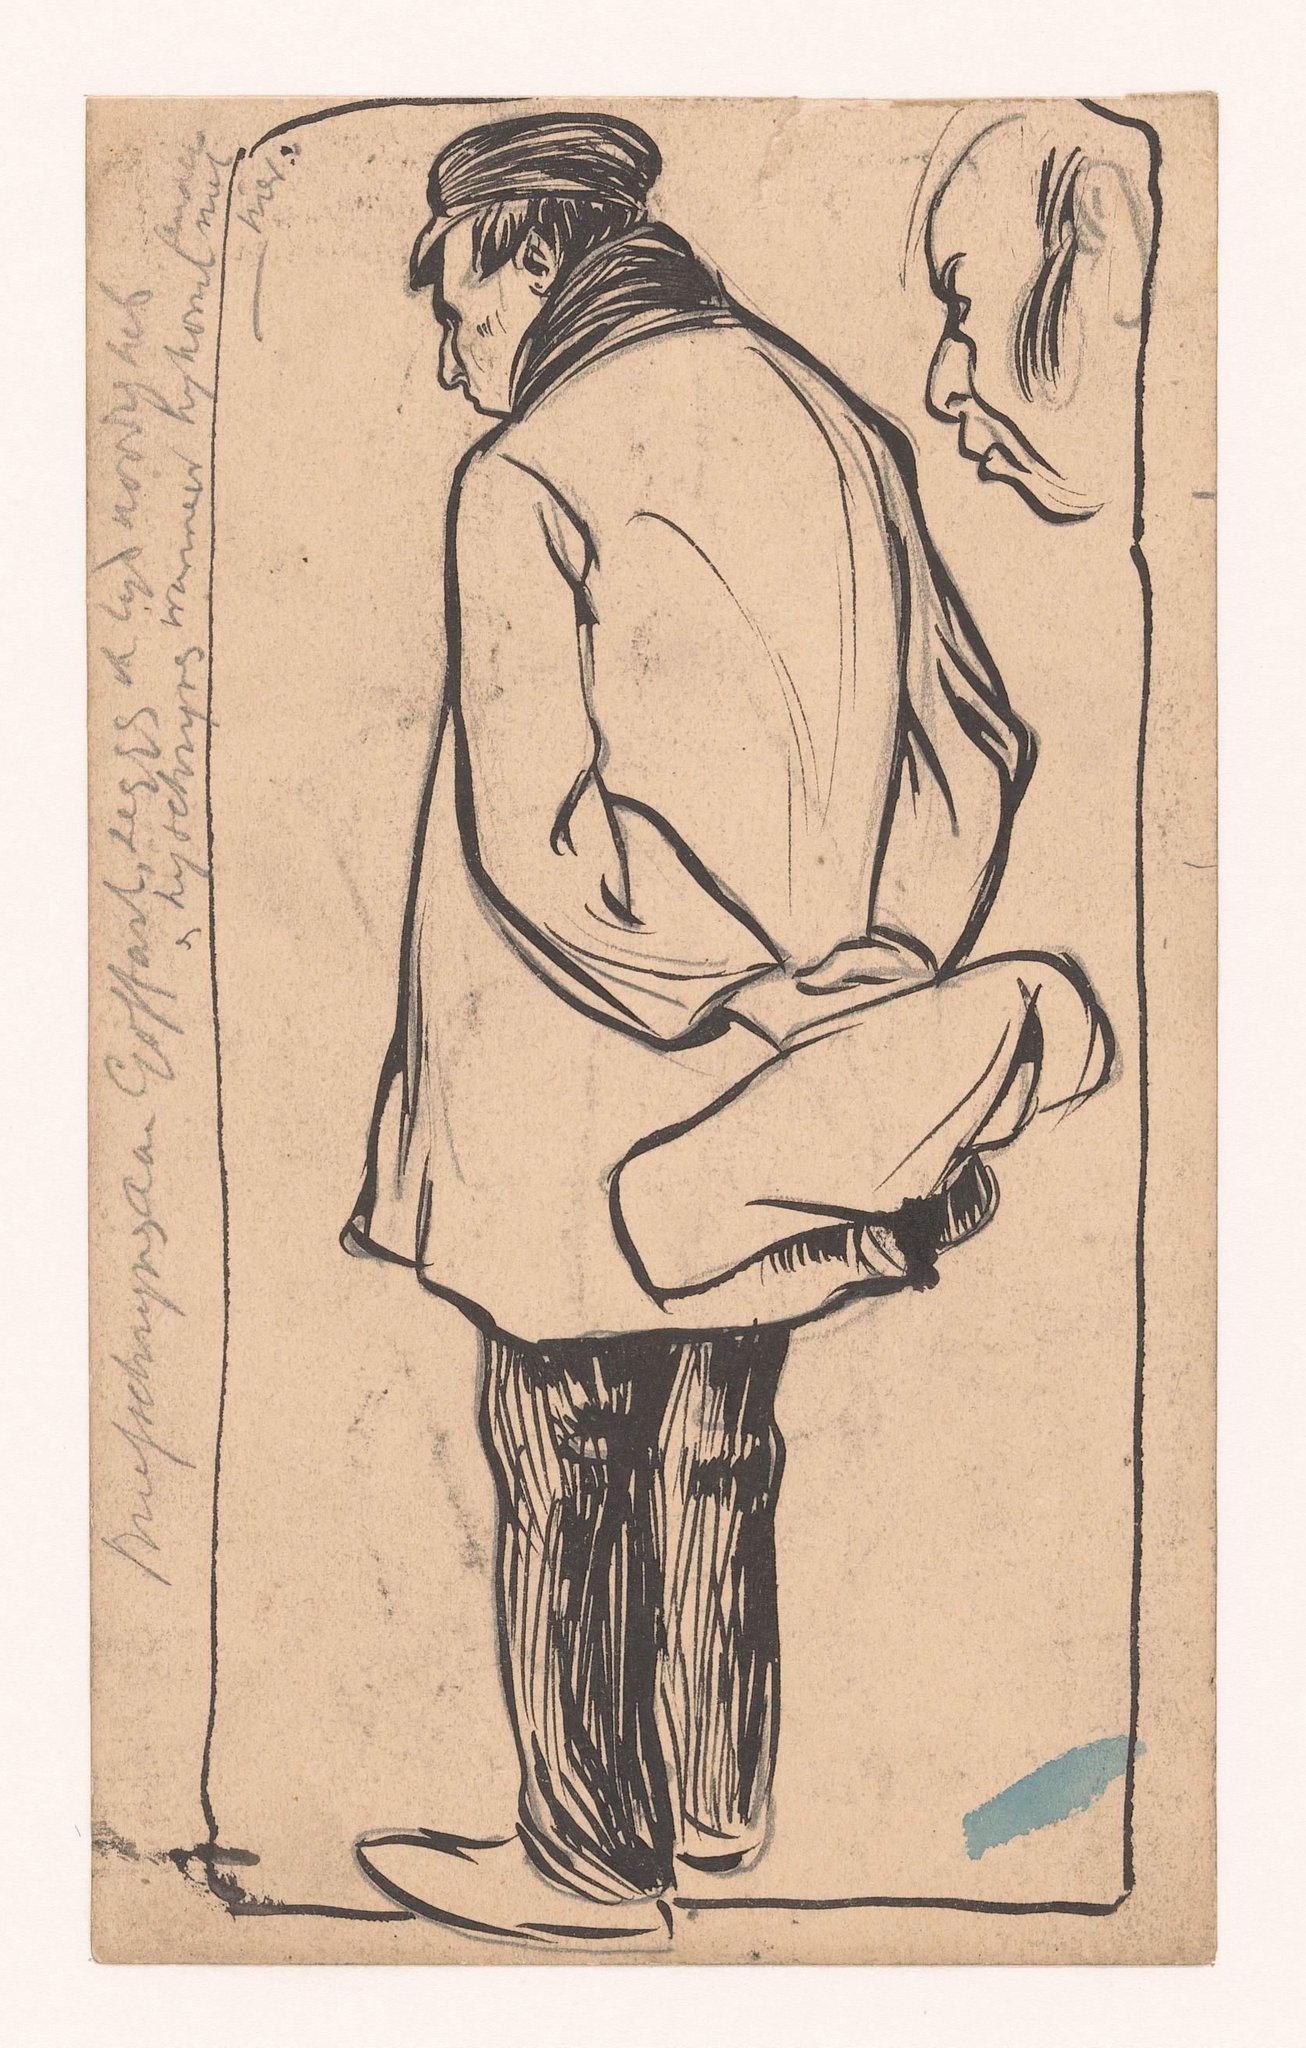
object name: drawing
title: Staande man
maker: jan de waardt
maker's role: draughtsman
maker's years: 1871-1909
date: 1881-1899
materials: ink, paper, pencil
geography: netherlands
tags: standing figure, working class, labourers, netherlands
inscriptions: inscription: ‘Briefschryven aan Goffart, zeggen ik tyd noodig heb & hy schryven wanneer hy komt anders niet hier.’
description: Staande man op de rug gezien naar links gewend, handen op de rug waar hij een pakje vasthoudt. Hij draagt een jas, sjaal en pet. Rechtsboven het hoofd van een booskijkende man. Mogelijk voor een politieke spotprent. Op de achterzijde van het blad een staande man, kniestuk, draagt pet, sjaal en jas.